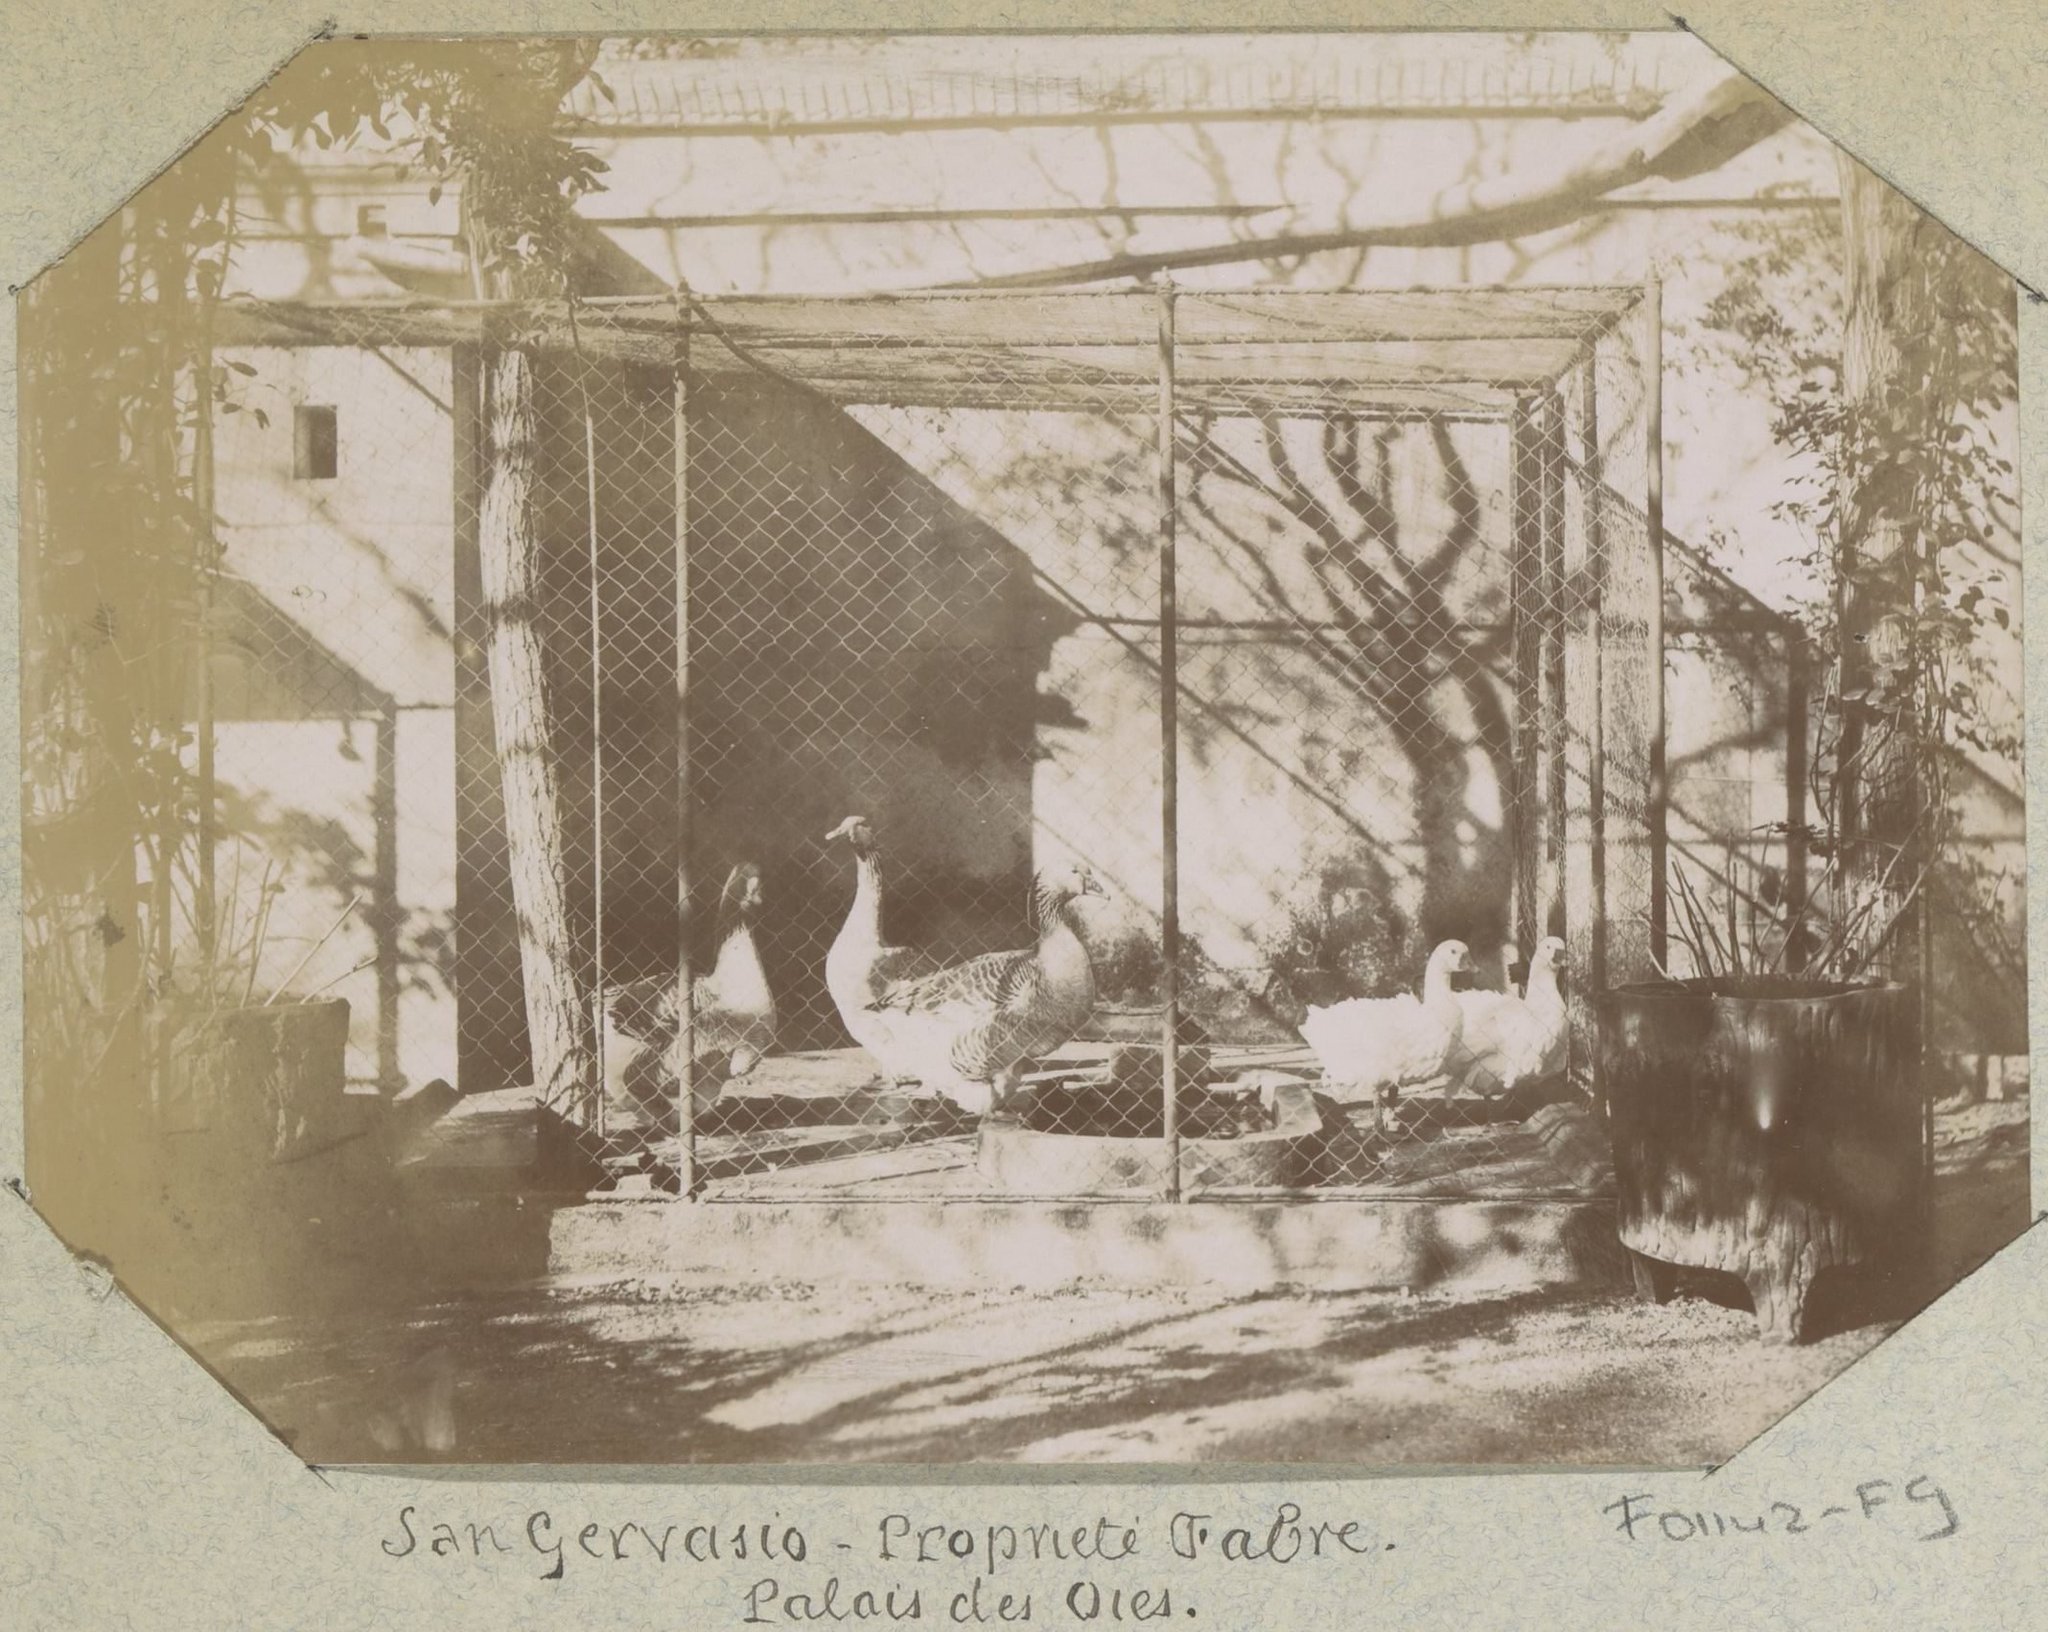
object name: photograph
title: Ganzen in een ren op het Propriété Fabre Palais des Ores in San Gervasio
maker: Anonymous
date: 1890-1900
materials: paper, photographic support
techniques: daylight paper print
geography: italy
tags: geese (domestic waterbirds) (+ animal cage), italy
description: Onderdeel van Album van een Franse amateur met foto's van Frankrijk, Algerije, Palmyra, de Wereldtentoonstelling van 1900 en van bekende Fransen.